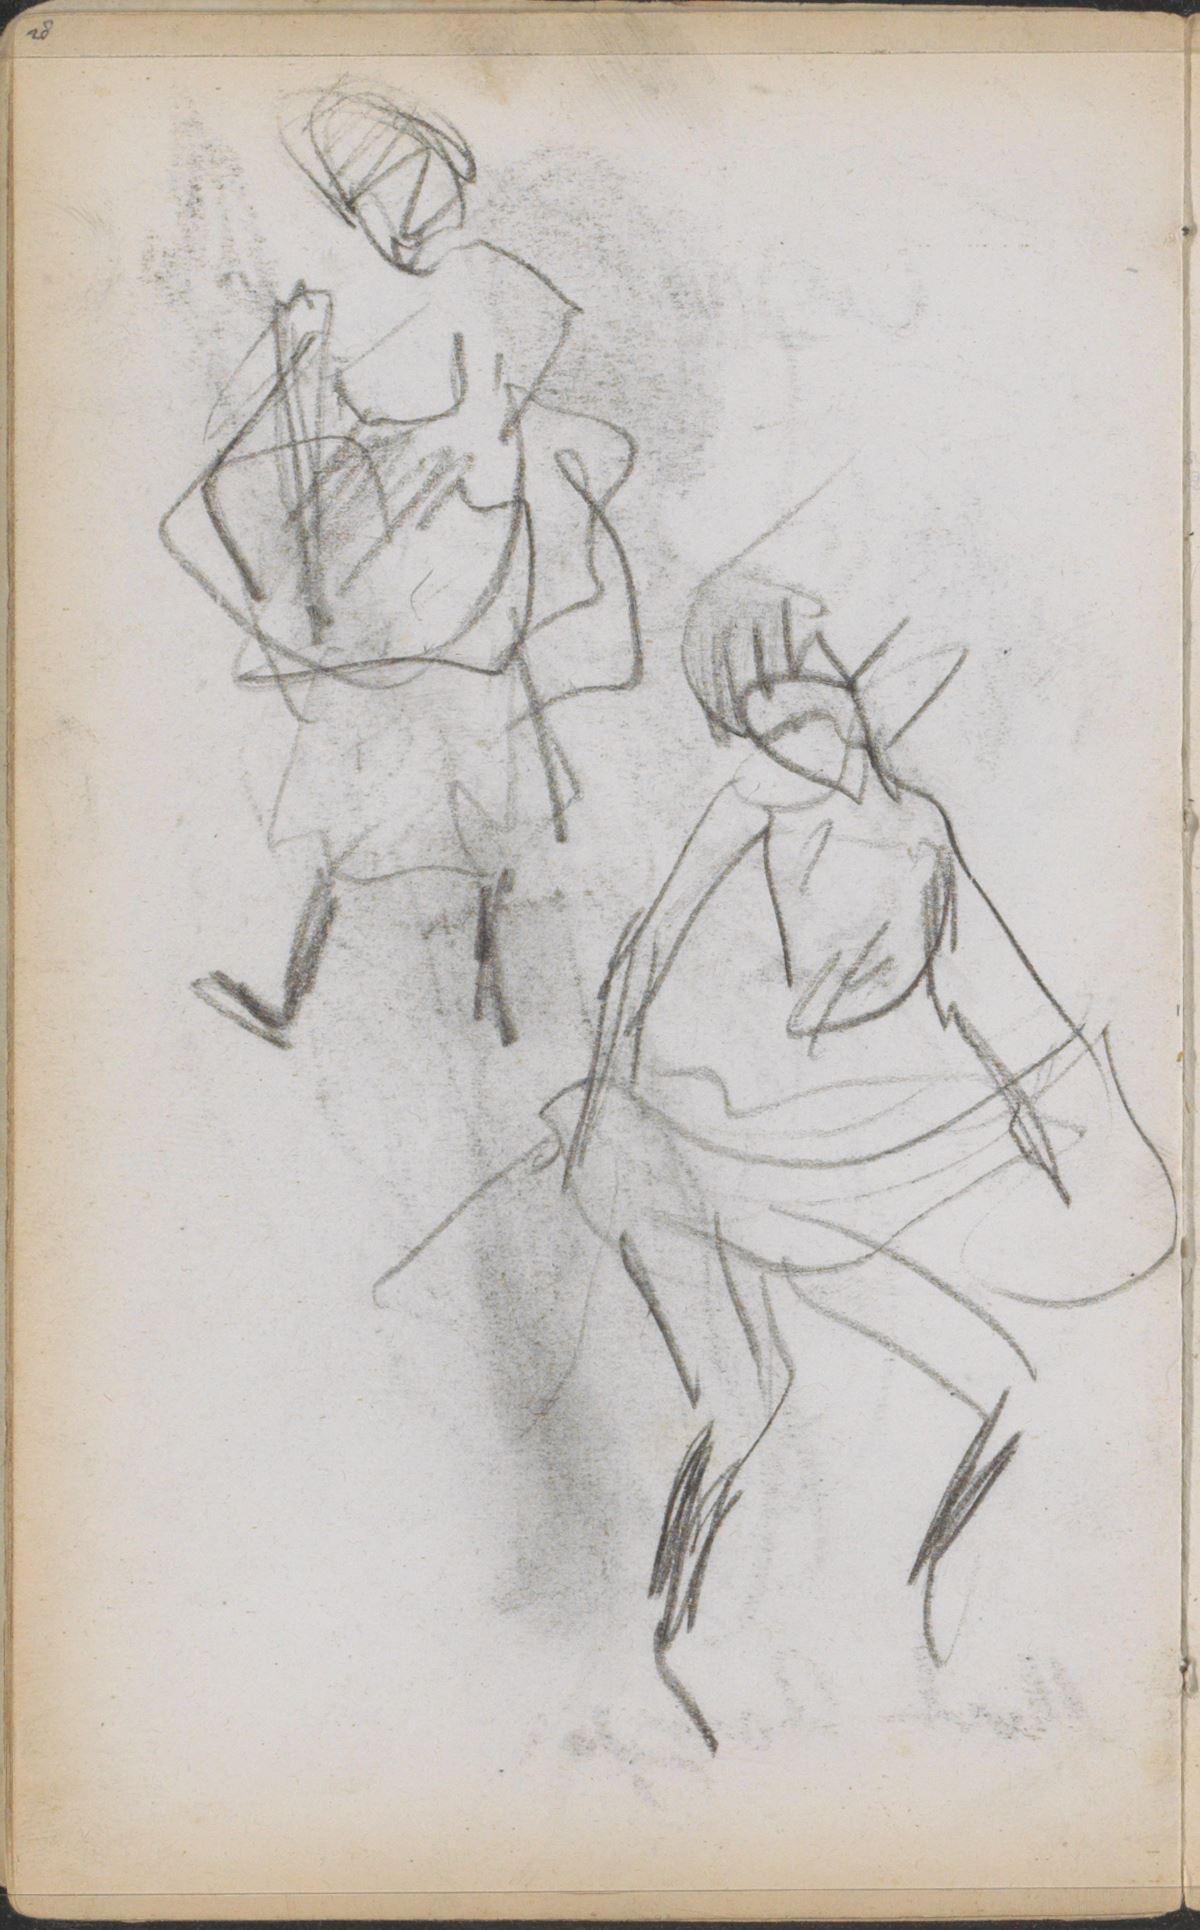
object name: sketchbook leaf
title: Danseressen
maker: marius bauer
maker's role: draughtsman, print maker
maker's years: 1867-1932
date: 1810-1891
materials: chalk, paper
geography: paris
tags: female dancer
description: Pagina 28 uit een schetsboek met 35 bladen.